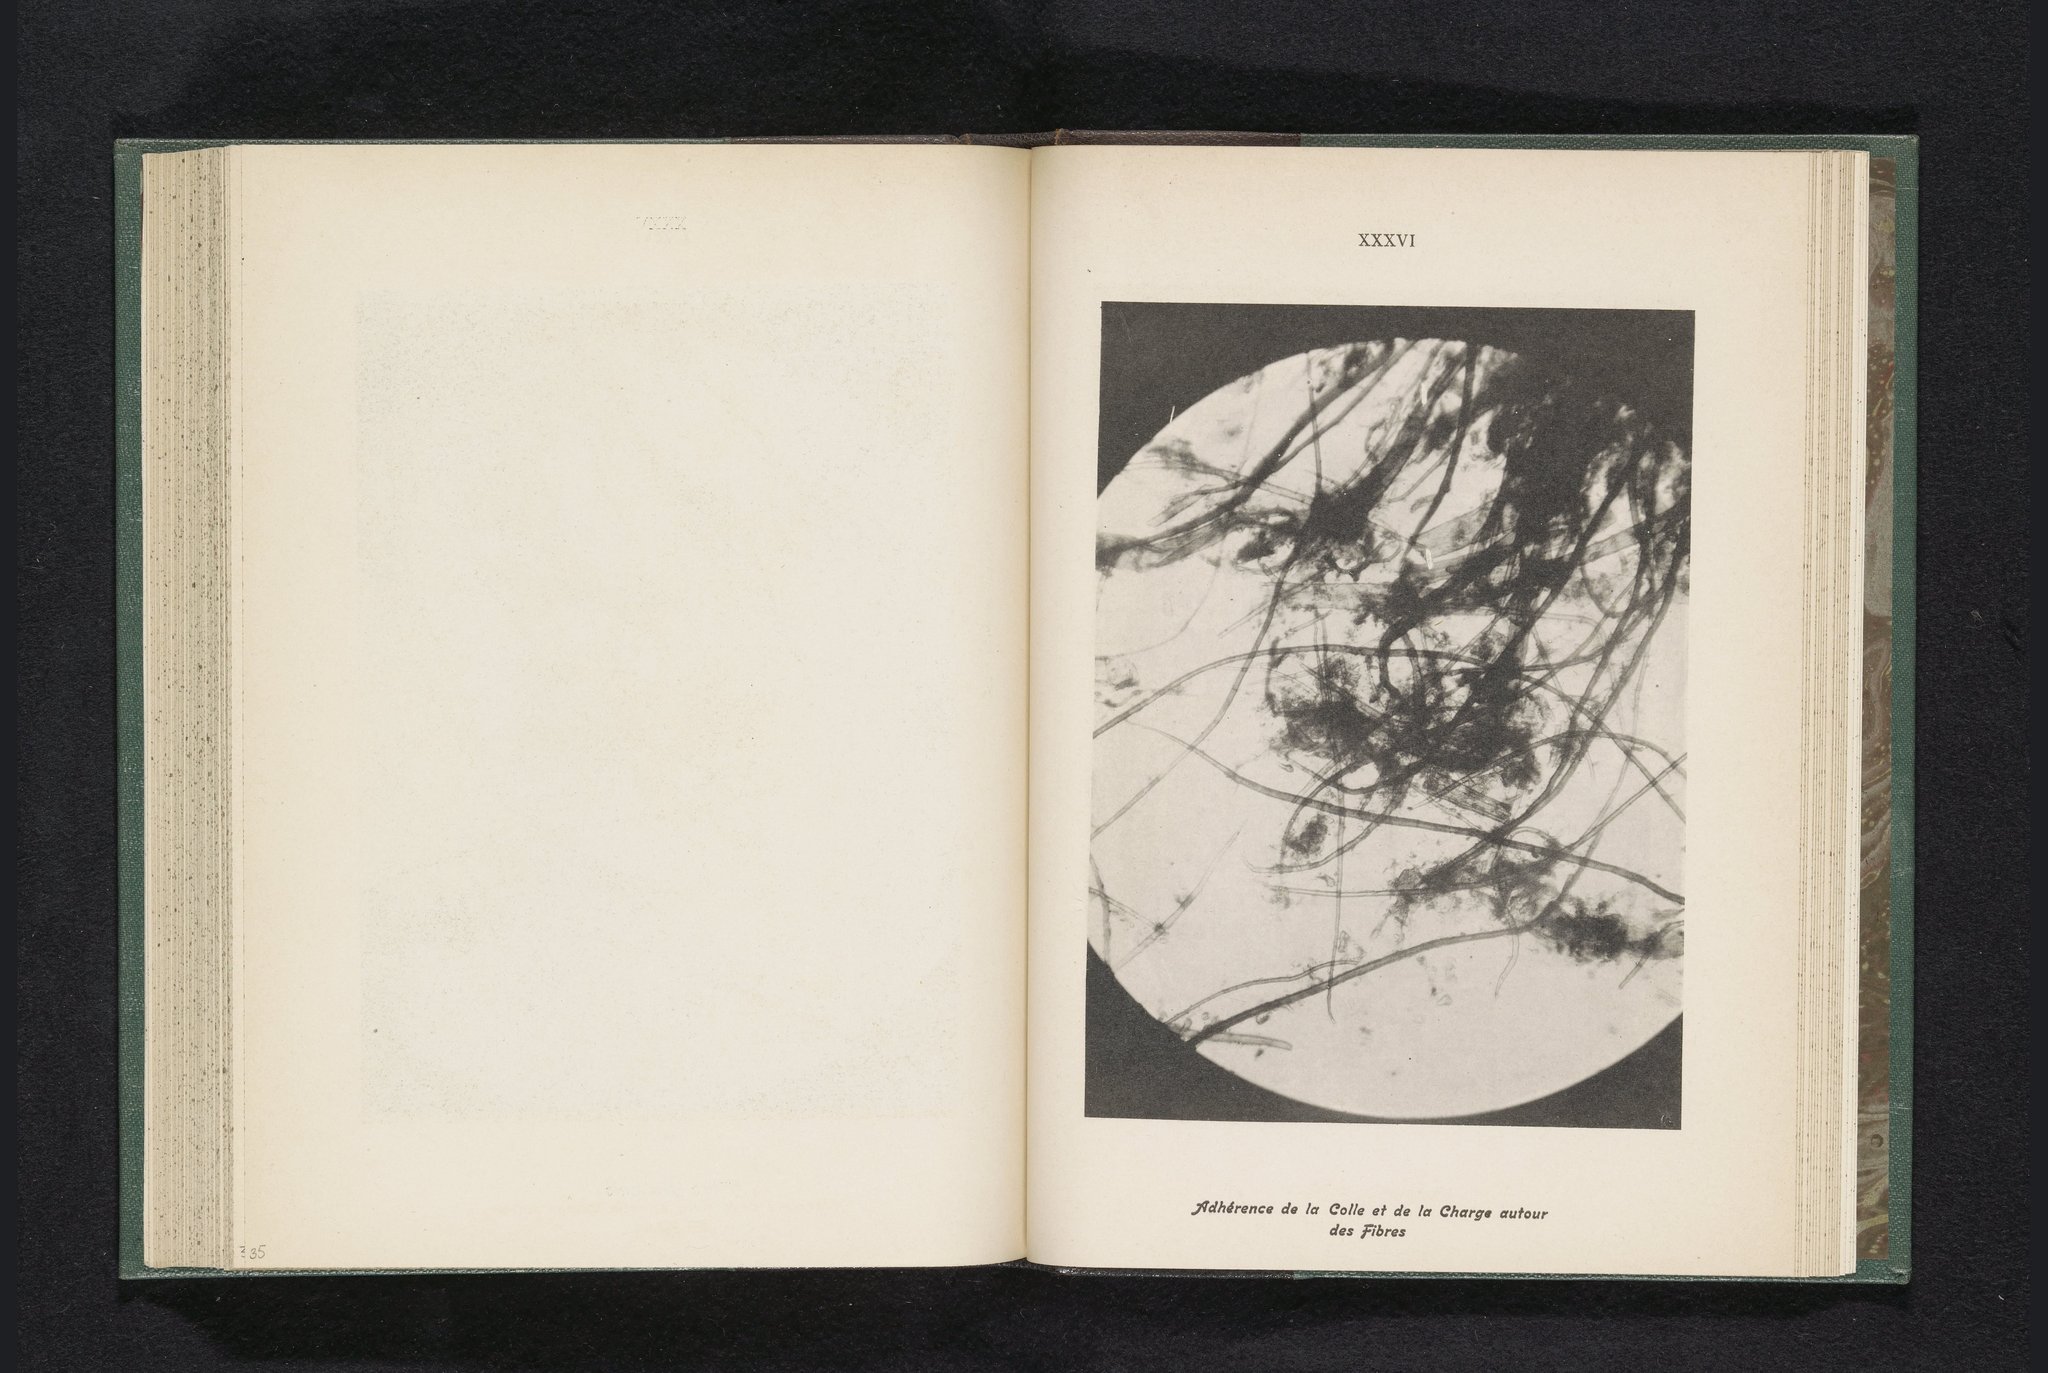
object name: photomechanical print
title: Adhérence de la colle et de la charge autour des fibres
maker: Anonymous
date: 1890-1900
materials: paper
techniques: photograph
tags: microscope (+ scientific research)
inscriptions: number: ‘XXXVI’